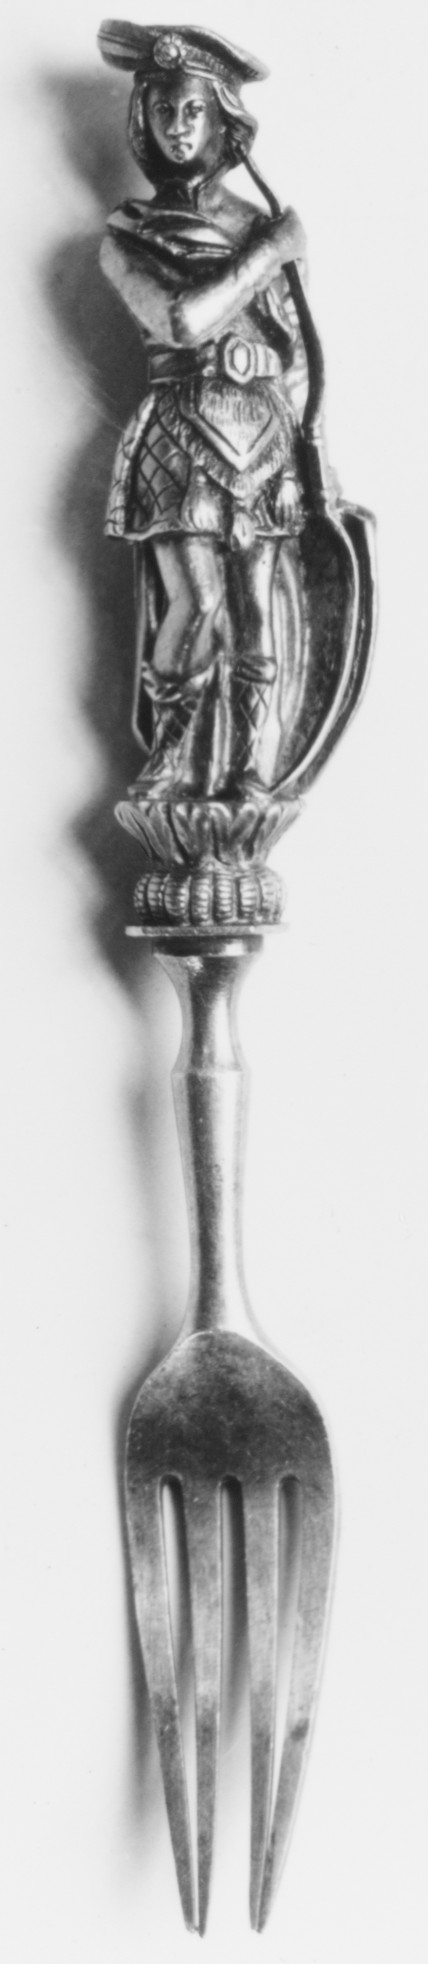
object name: fork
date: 1801-1900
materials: silver gilt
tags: human figures